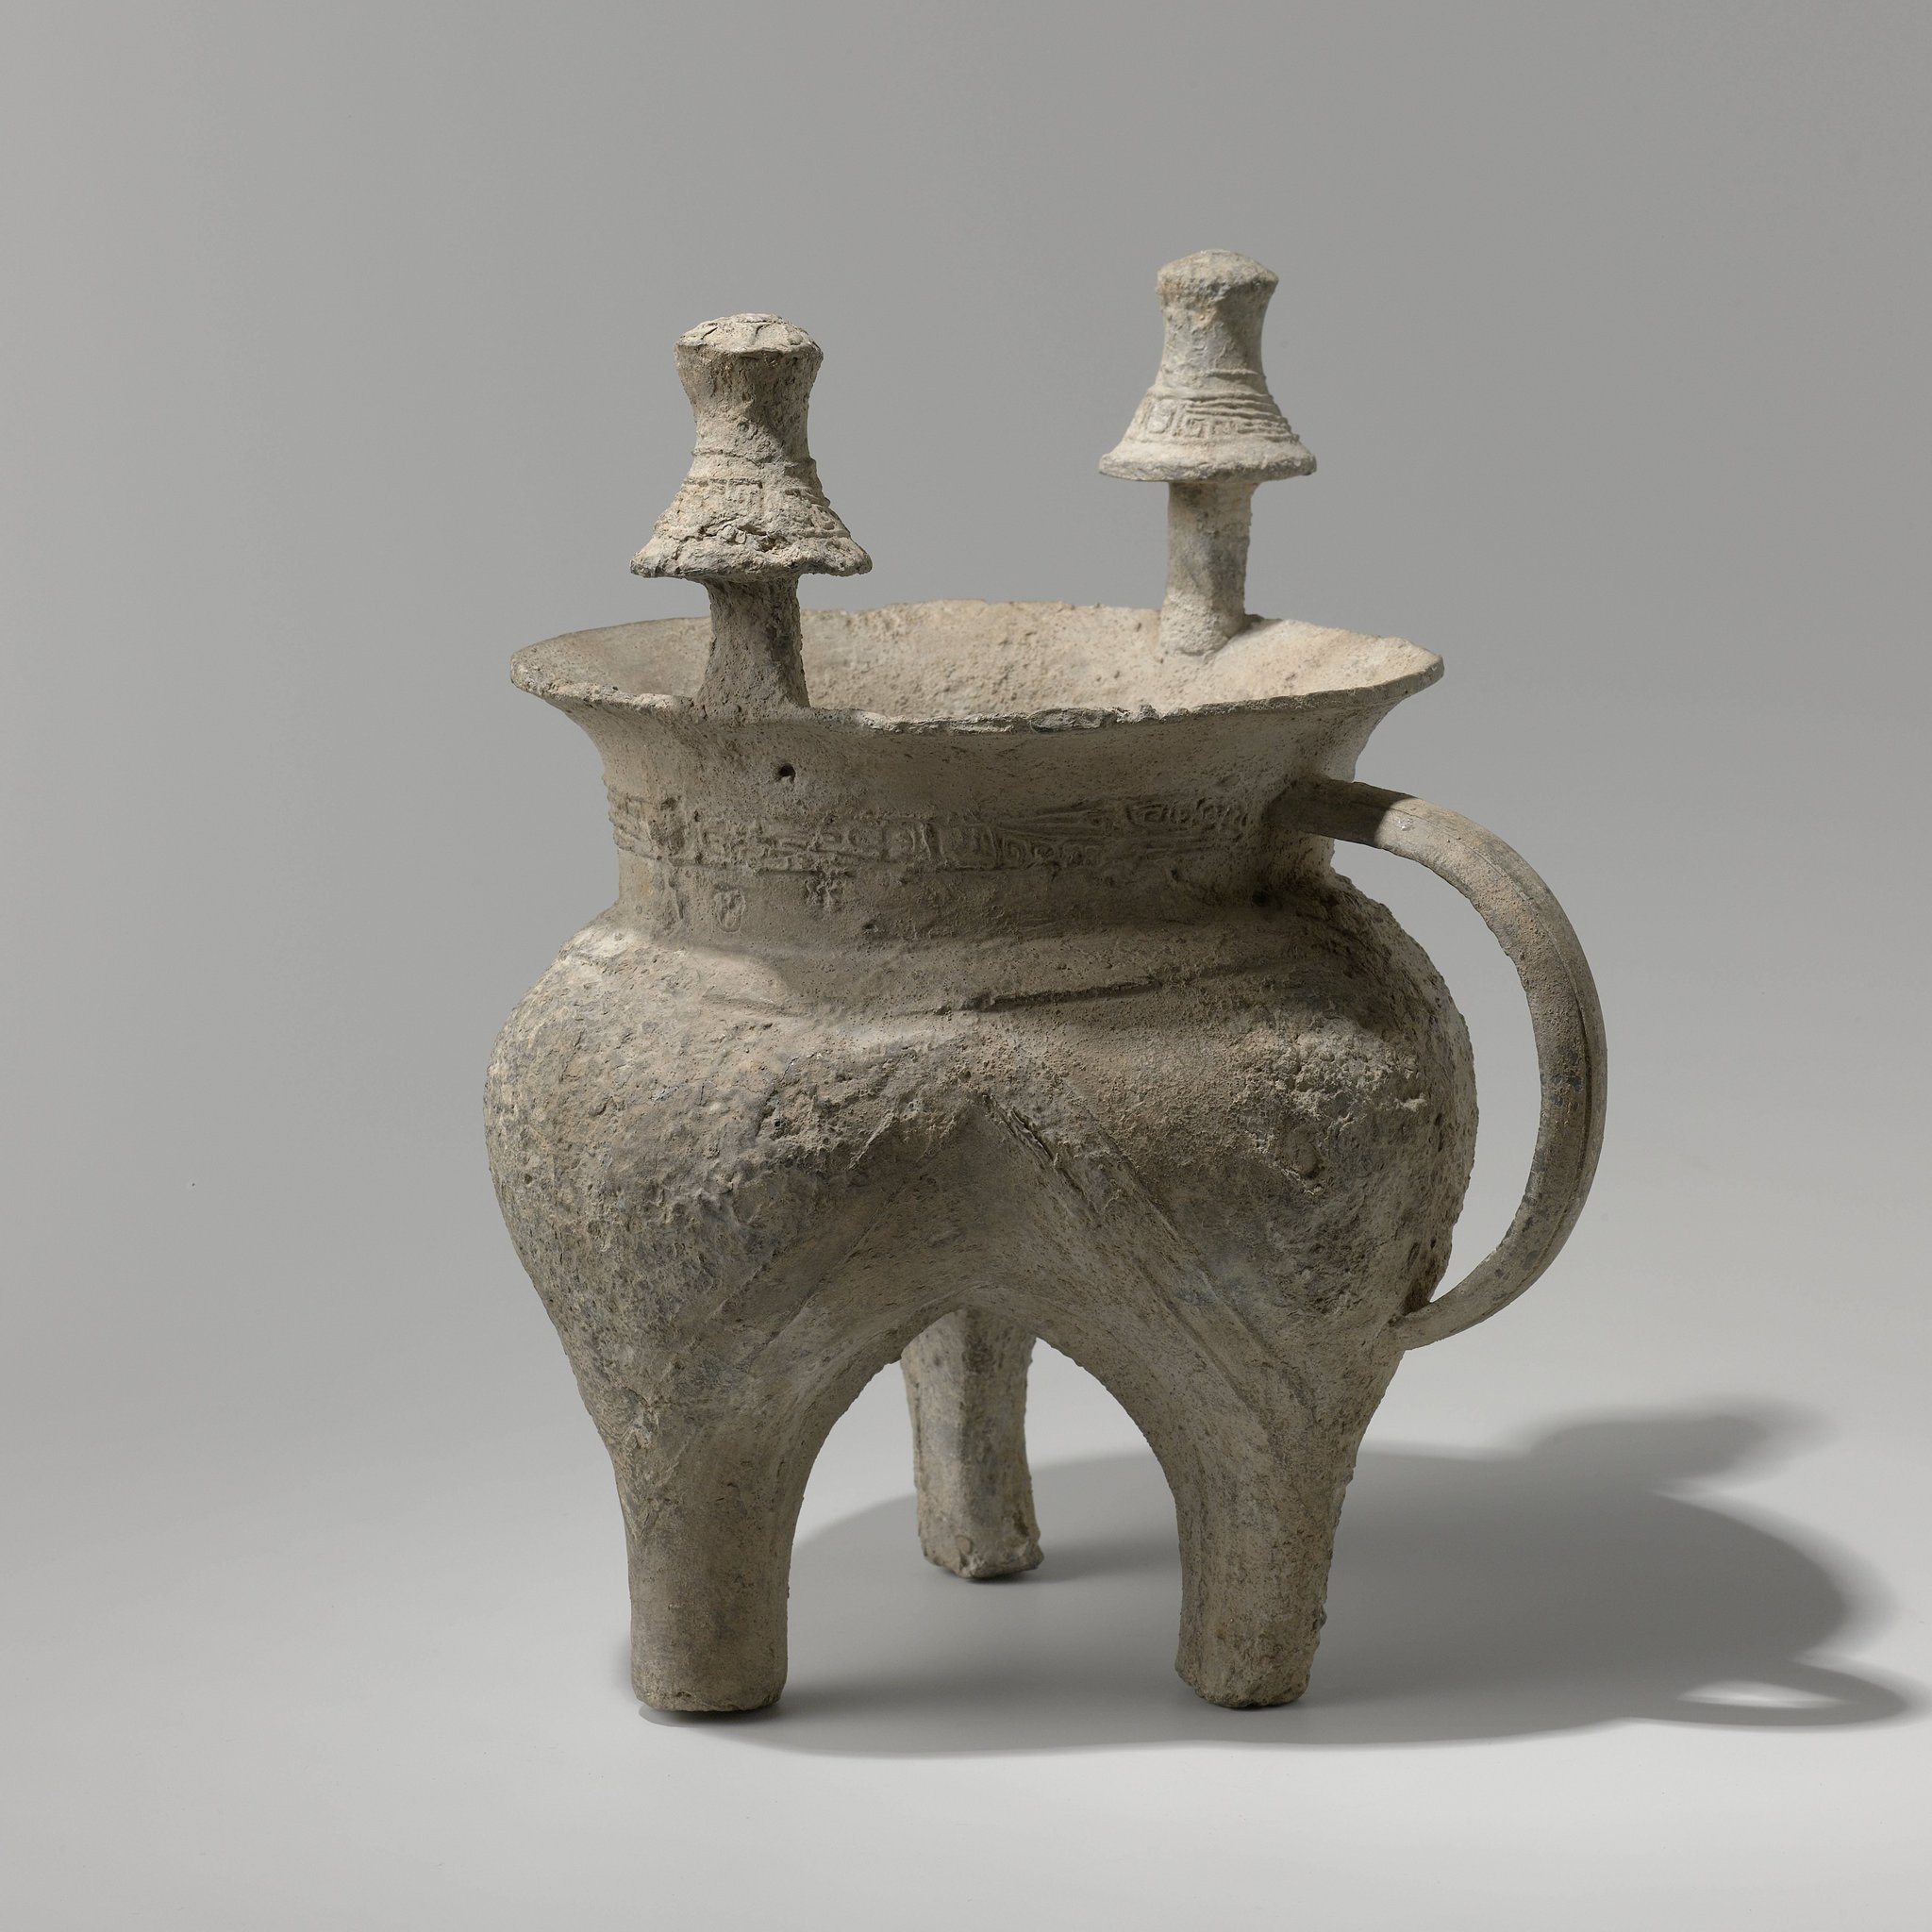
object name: vessel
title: Ritual Cauldron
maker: Anonymous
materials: antimony, lead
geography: china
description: This cauldron was used for libations of wine during ritual offerings. It is known as jia. Ancient Chinese bronzes were made of alloys of copper and tin, and sometimes also lead. These materials were heated into a molten mass and subsequently cast in the desired form in ceramic moulds.